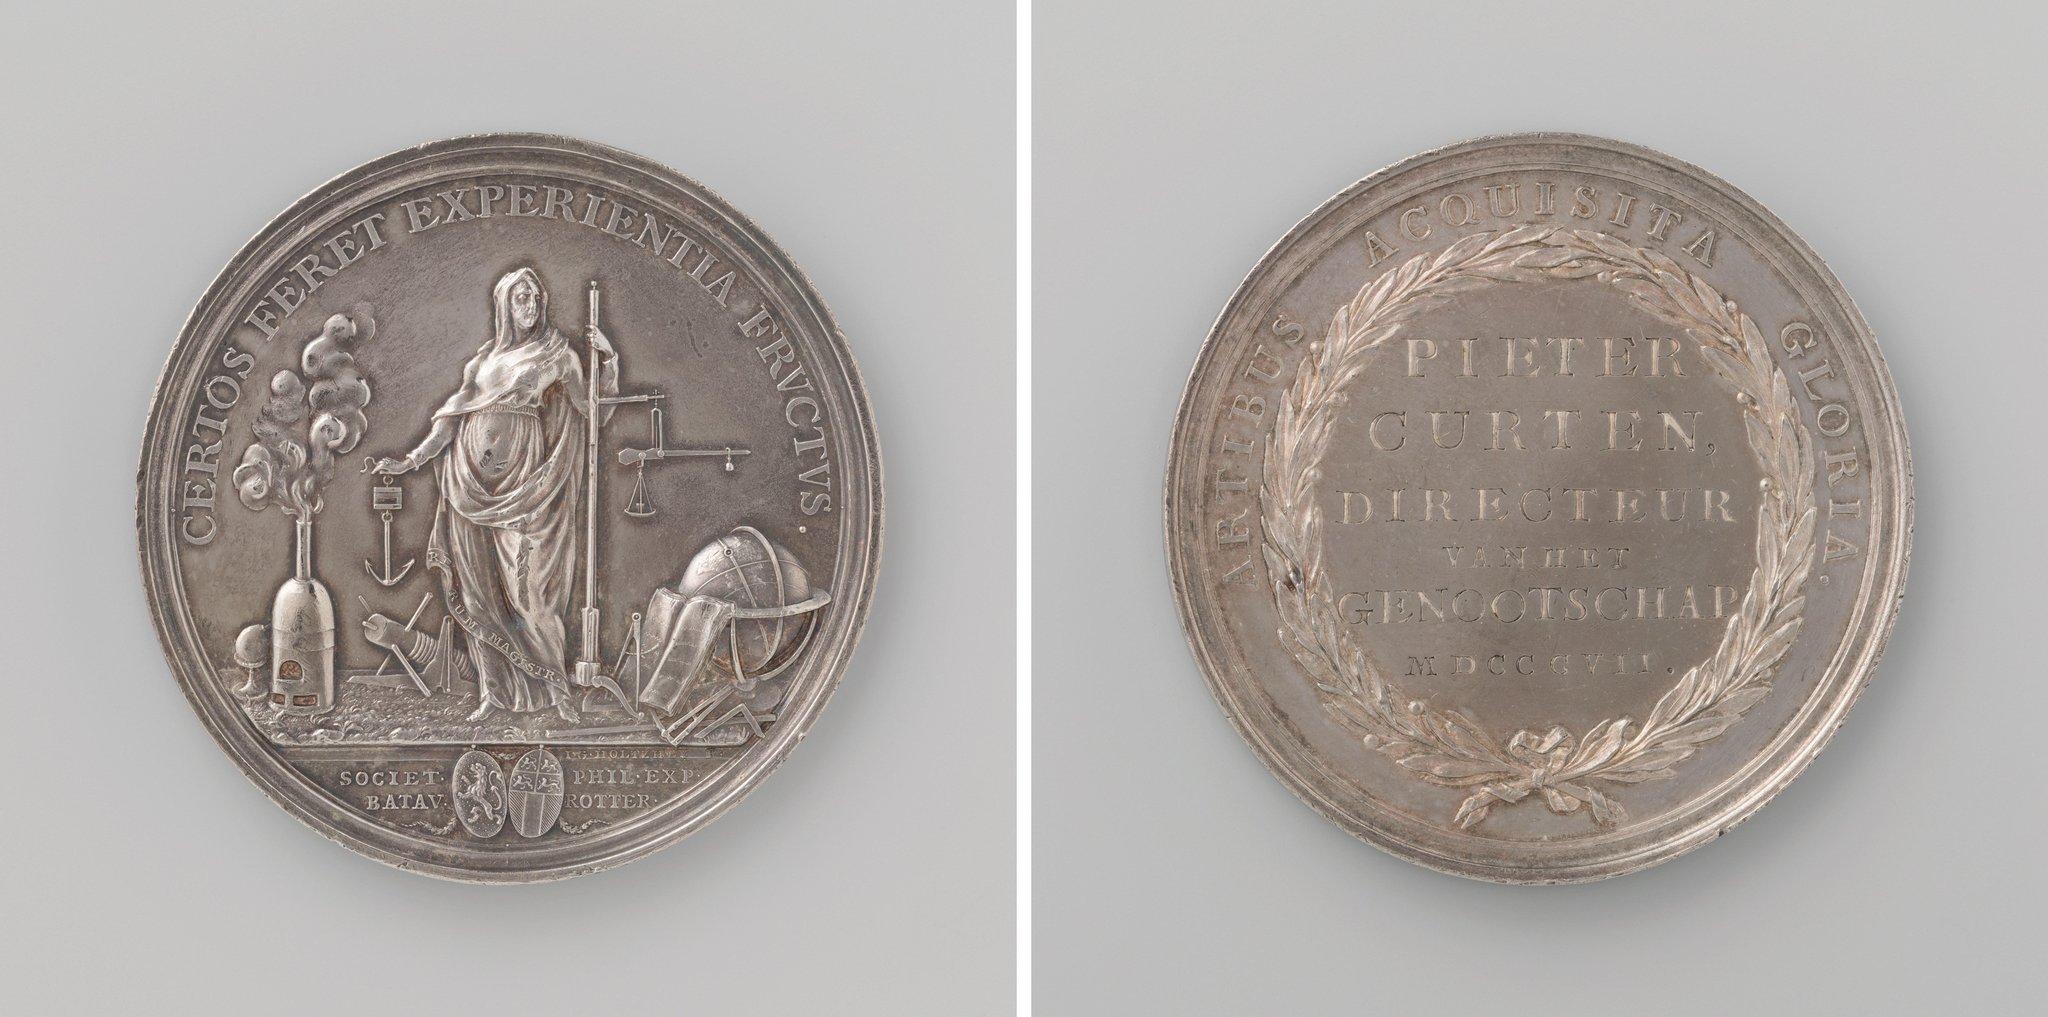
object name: medal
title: Bataafsch Genootschap van proefondervindelijke wijsbegeerte, penning vereerd aan Pieter Curten, directeur van het genootschap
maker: johan george holtzhey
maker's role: mintmaster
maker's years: 1726-1808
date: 1769-1807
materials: silver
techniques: engraving, striking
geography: amsterdam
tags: rotterdam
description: Prize medal silver, 1807 Awarded by the Bataafsch Genootschap der Proefondervindelijke Wijsbegeerte, the society of 'experimental philosophy', of Rotterdam to Pieter Curten, director of the society since 1805.